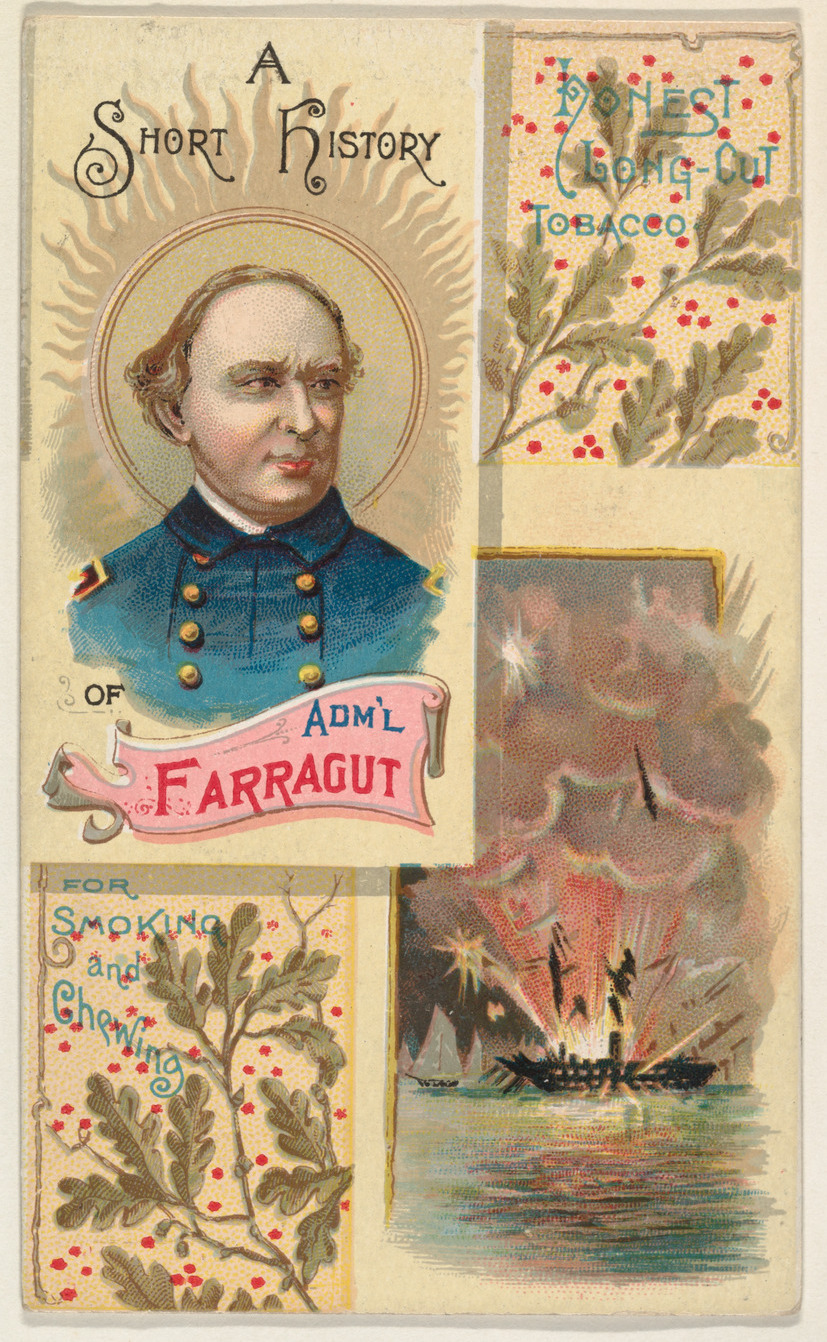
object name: print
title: A Short History of Admiral Farragut, from the Histories of Generals series (N114) issued by W. Duke, Sons & Co. to promote Honest Long Cut Smoking and Chewing Tobacco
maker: w. duke, sons & co.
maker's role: publisher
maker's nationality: american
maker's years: 1870-1920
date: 1888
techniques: color lithograph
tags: men,admirals